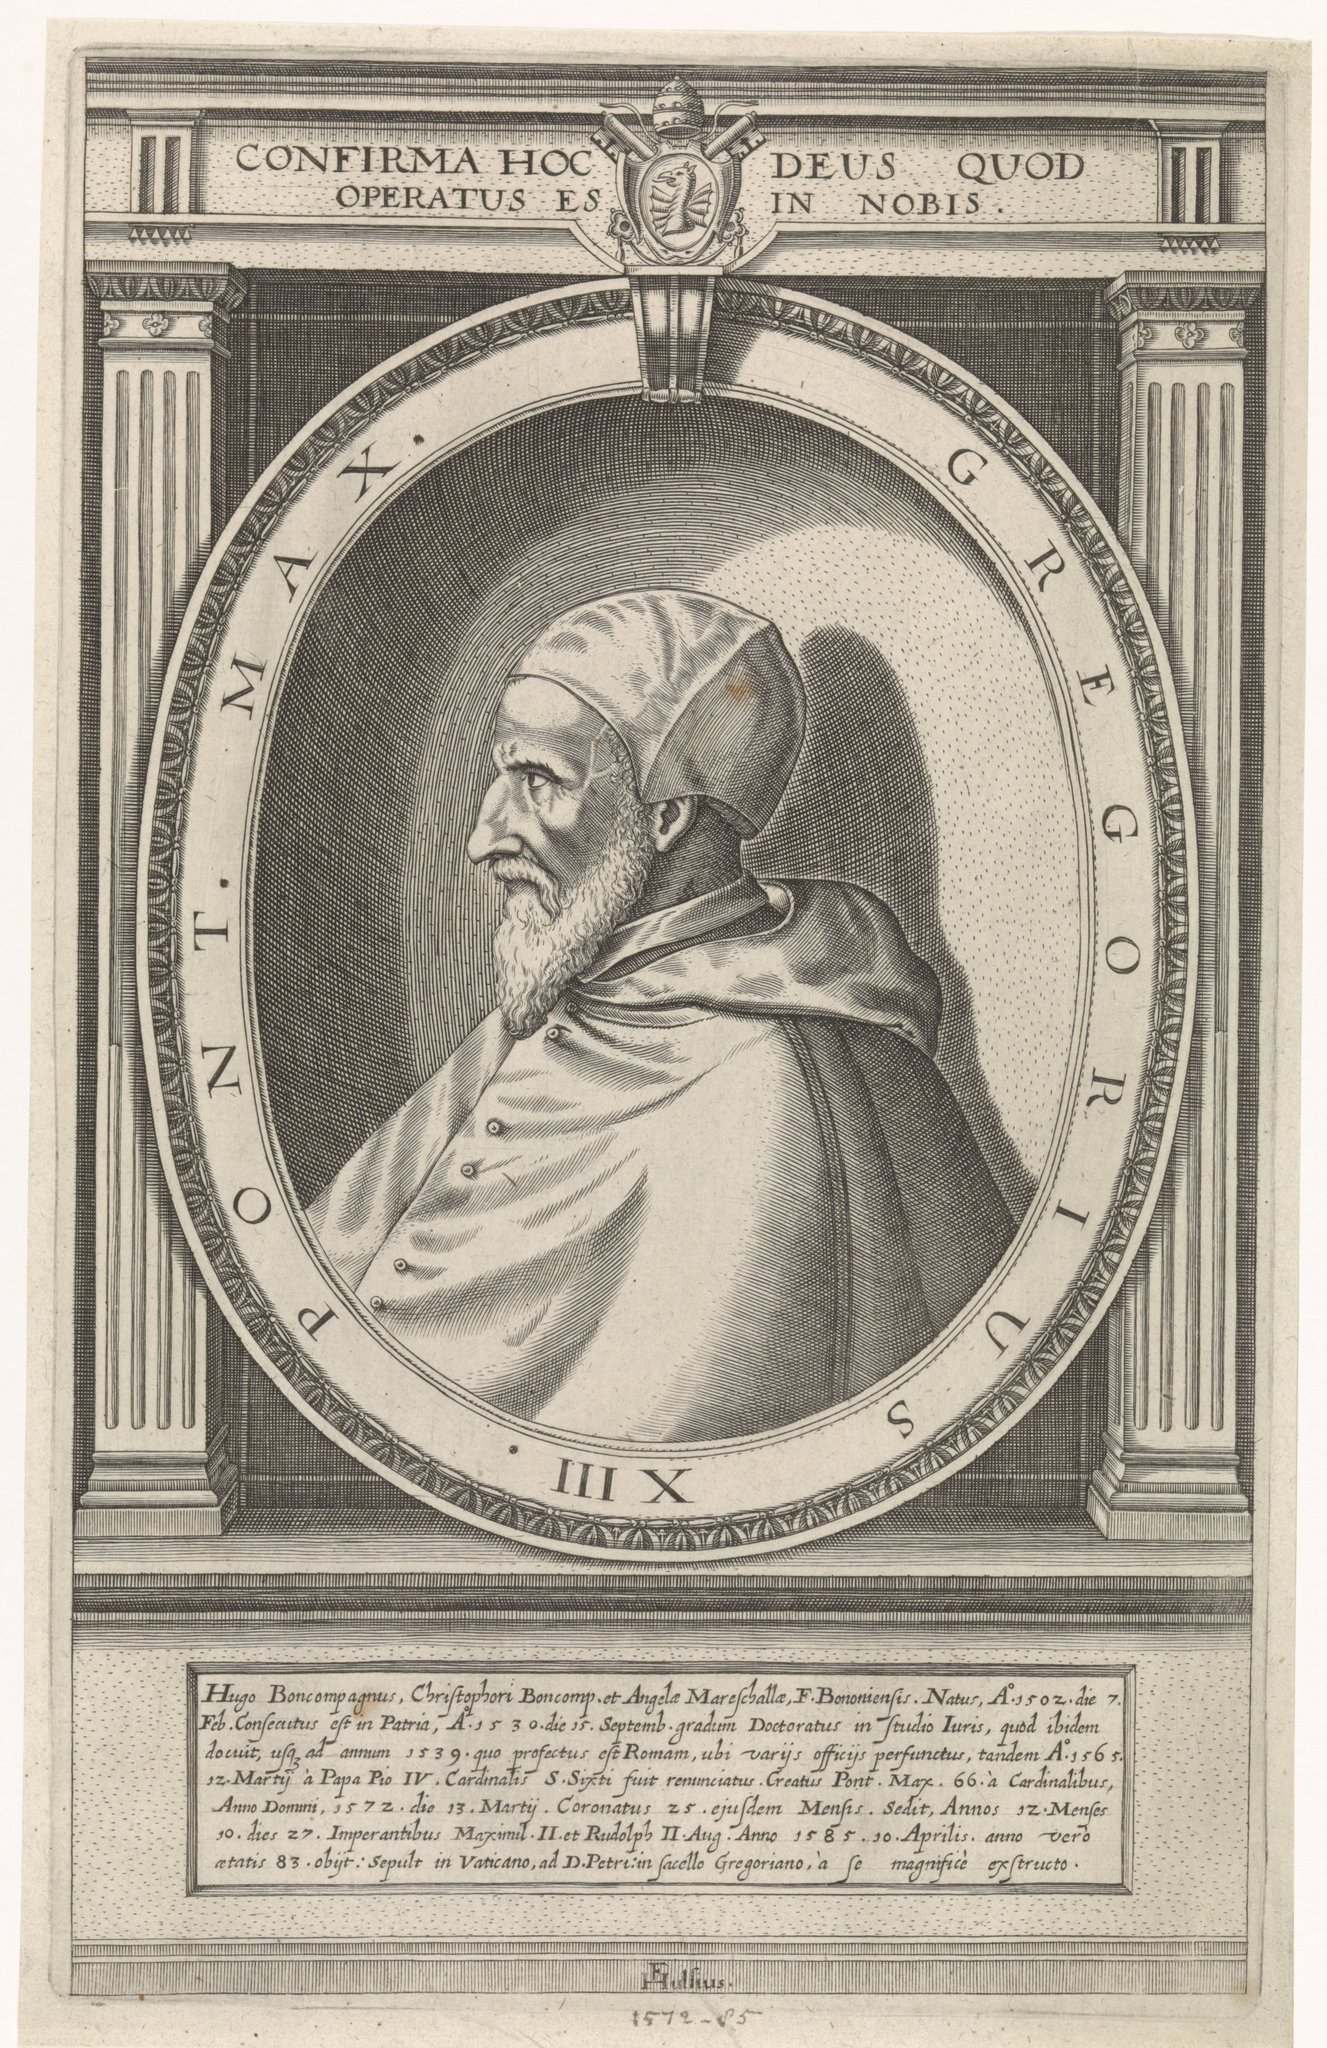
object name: print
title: Portret van paus Gregorius XIII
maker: friedrich van hulsen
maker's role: print maker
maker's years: 1580-1660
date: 1590-1665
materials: paper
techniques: engraving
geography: germany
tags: rome, gregorius xiii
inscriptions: inscription: ‘1572-85’, collector's mark: Lugt 2228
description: Portret van paus Gregorius XIII gehuld in het pauselijk gewaad, het hoofd getooid met een camauro. Buste en profil naar links in een ovale lijst met randschrift. Boven een tweeregelige tekst in het Latijn en midden boven is zijn pauselijk wapen afgebeeld. Onder het portret zeven tekstregels in het Latijn.